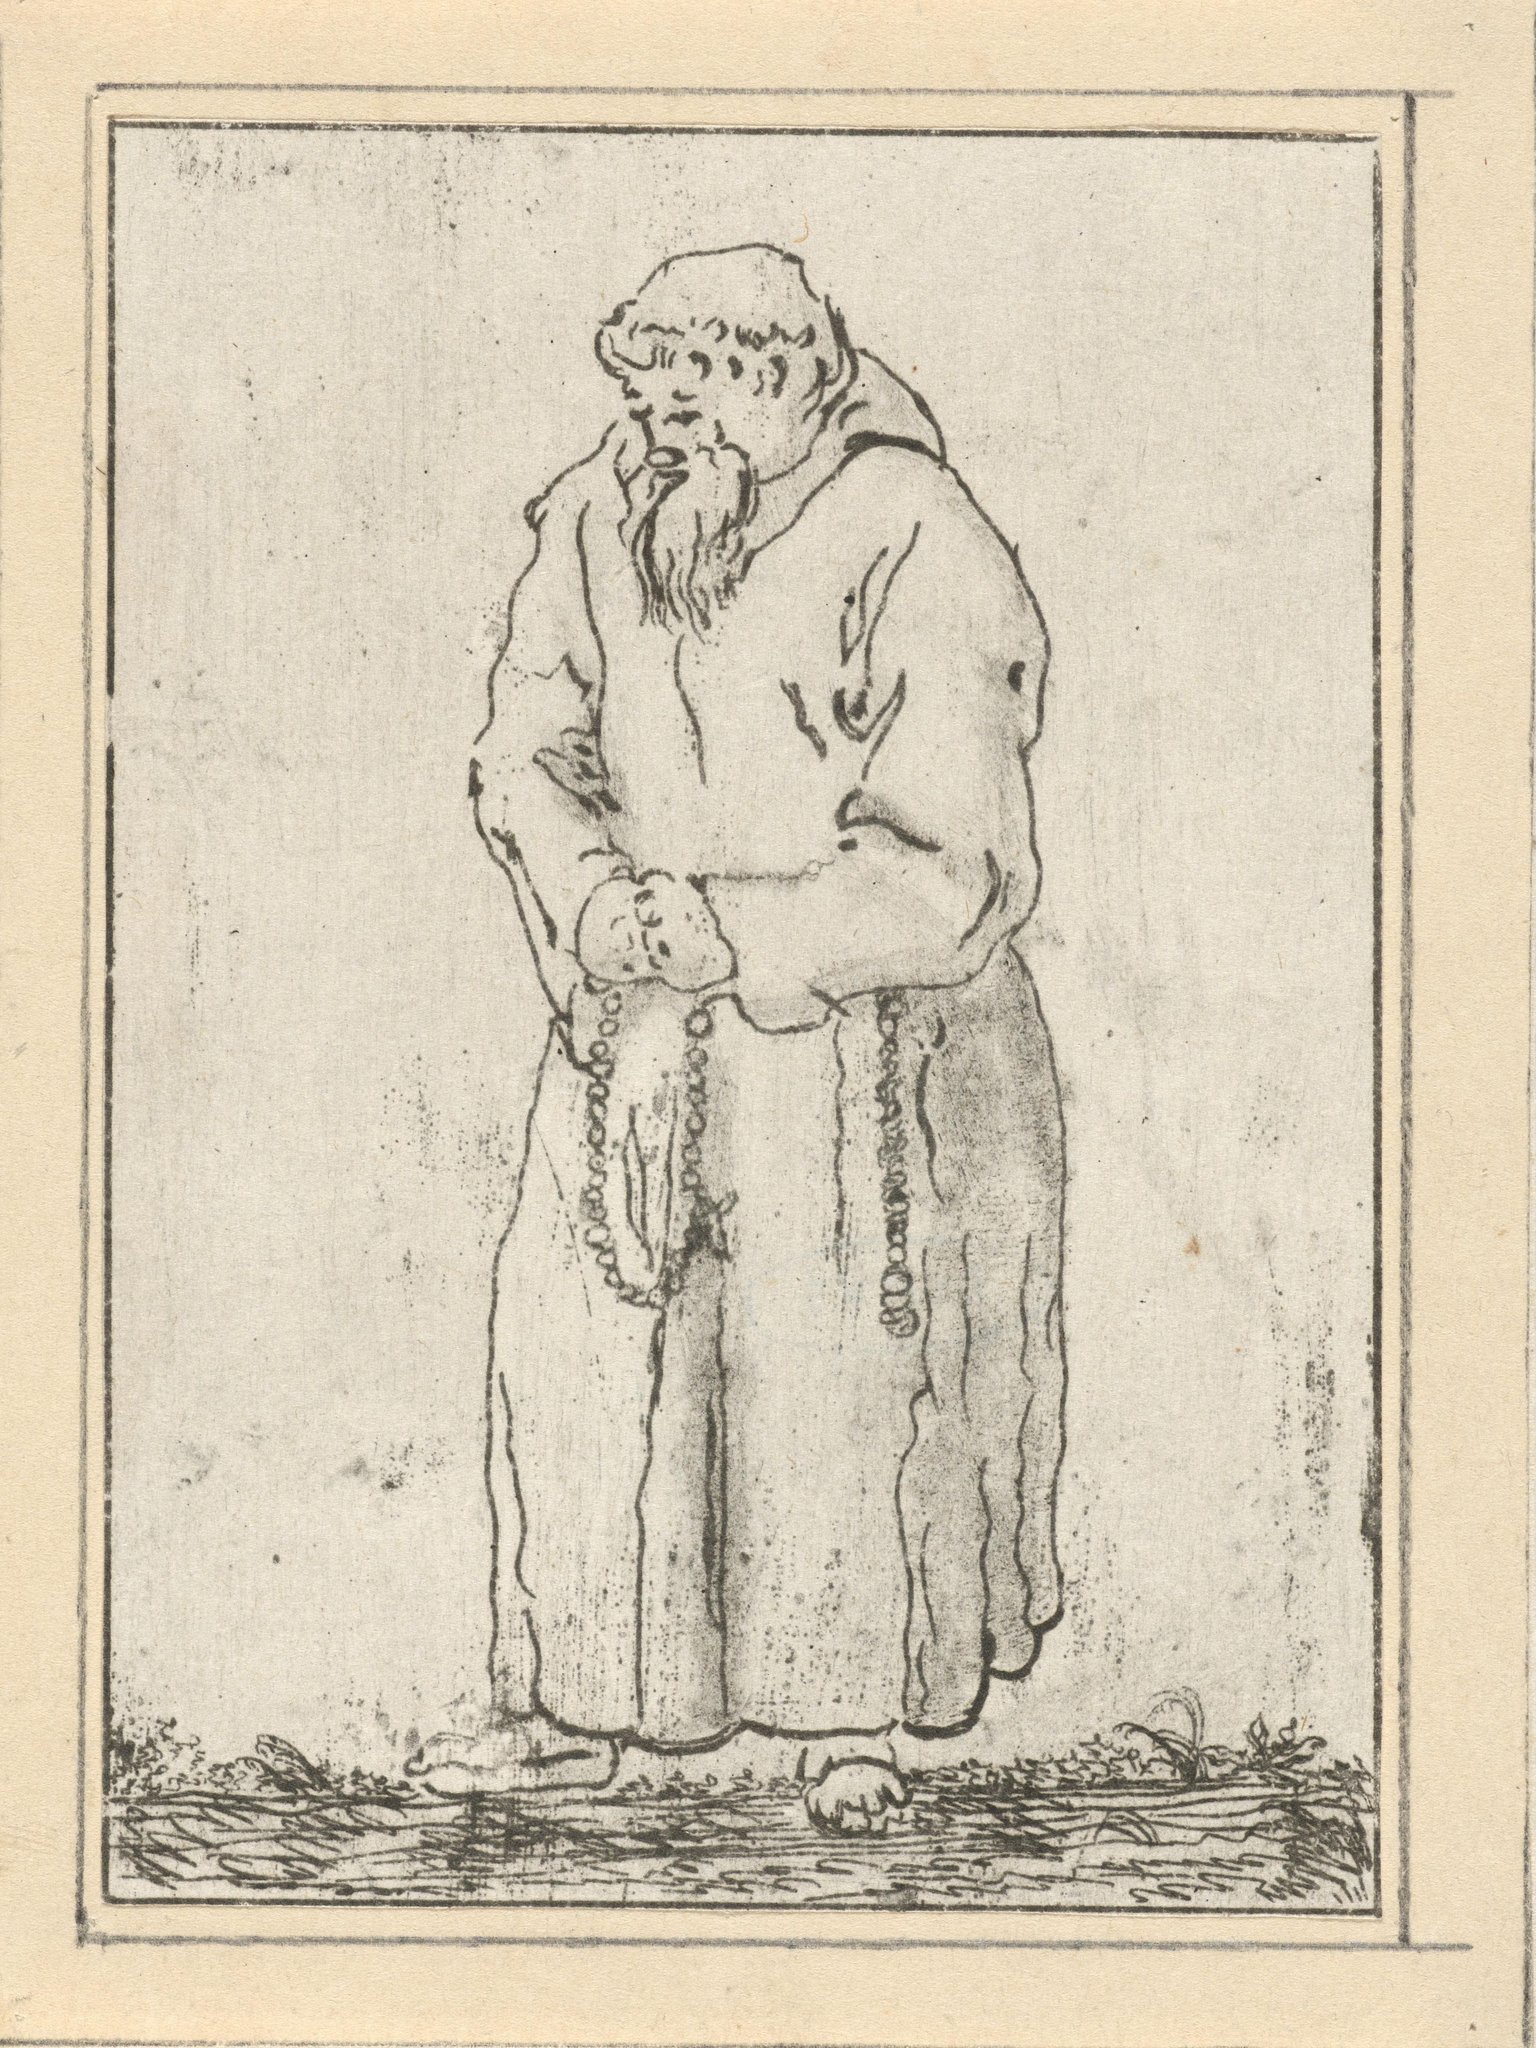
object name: print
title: Monnik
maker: jacob hoolaart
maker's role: print maker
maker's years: 1713-1789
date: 1728-1789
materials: paper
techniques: etching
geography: dordrecht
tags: aids for prayer, e.g. rosary, monk(s), friar(s)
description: Staande monnik met een rozenkrans in zijn hand.